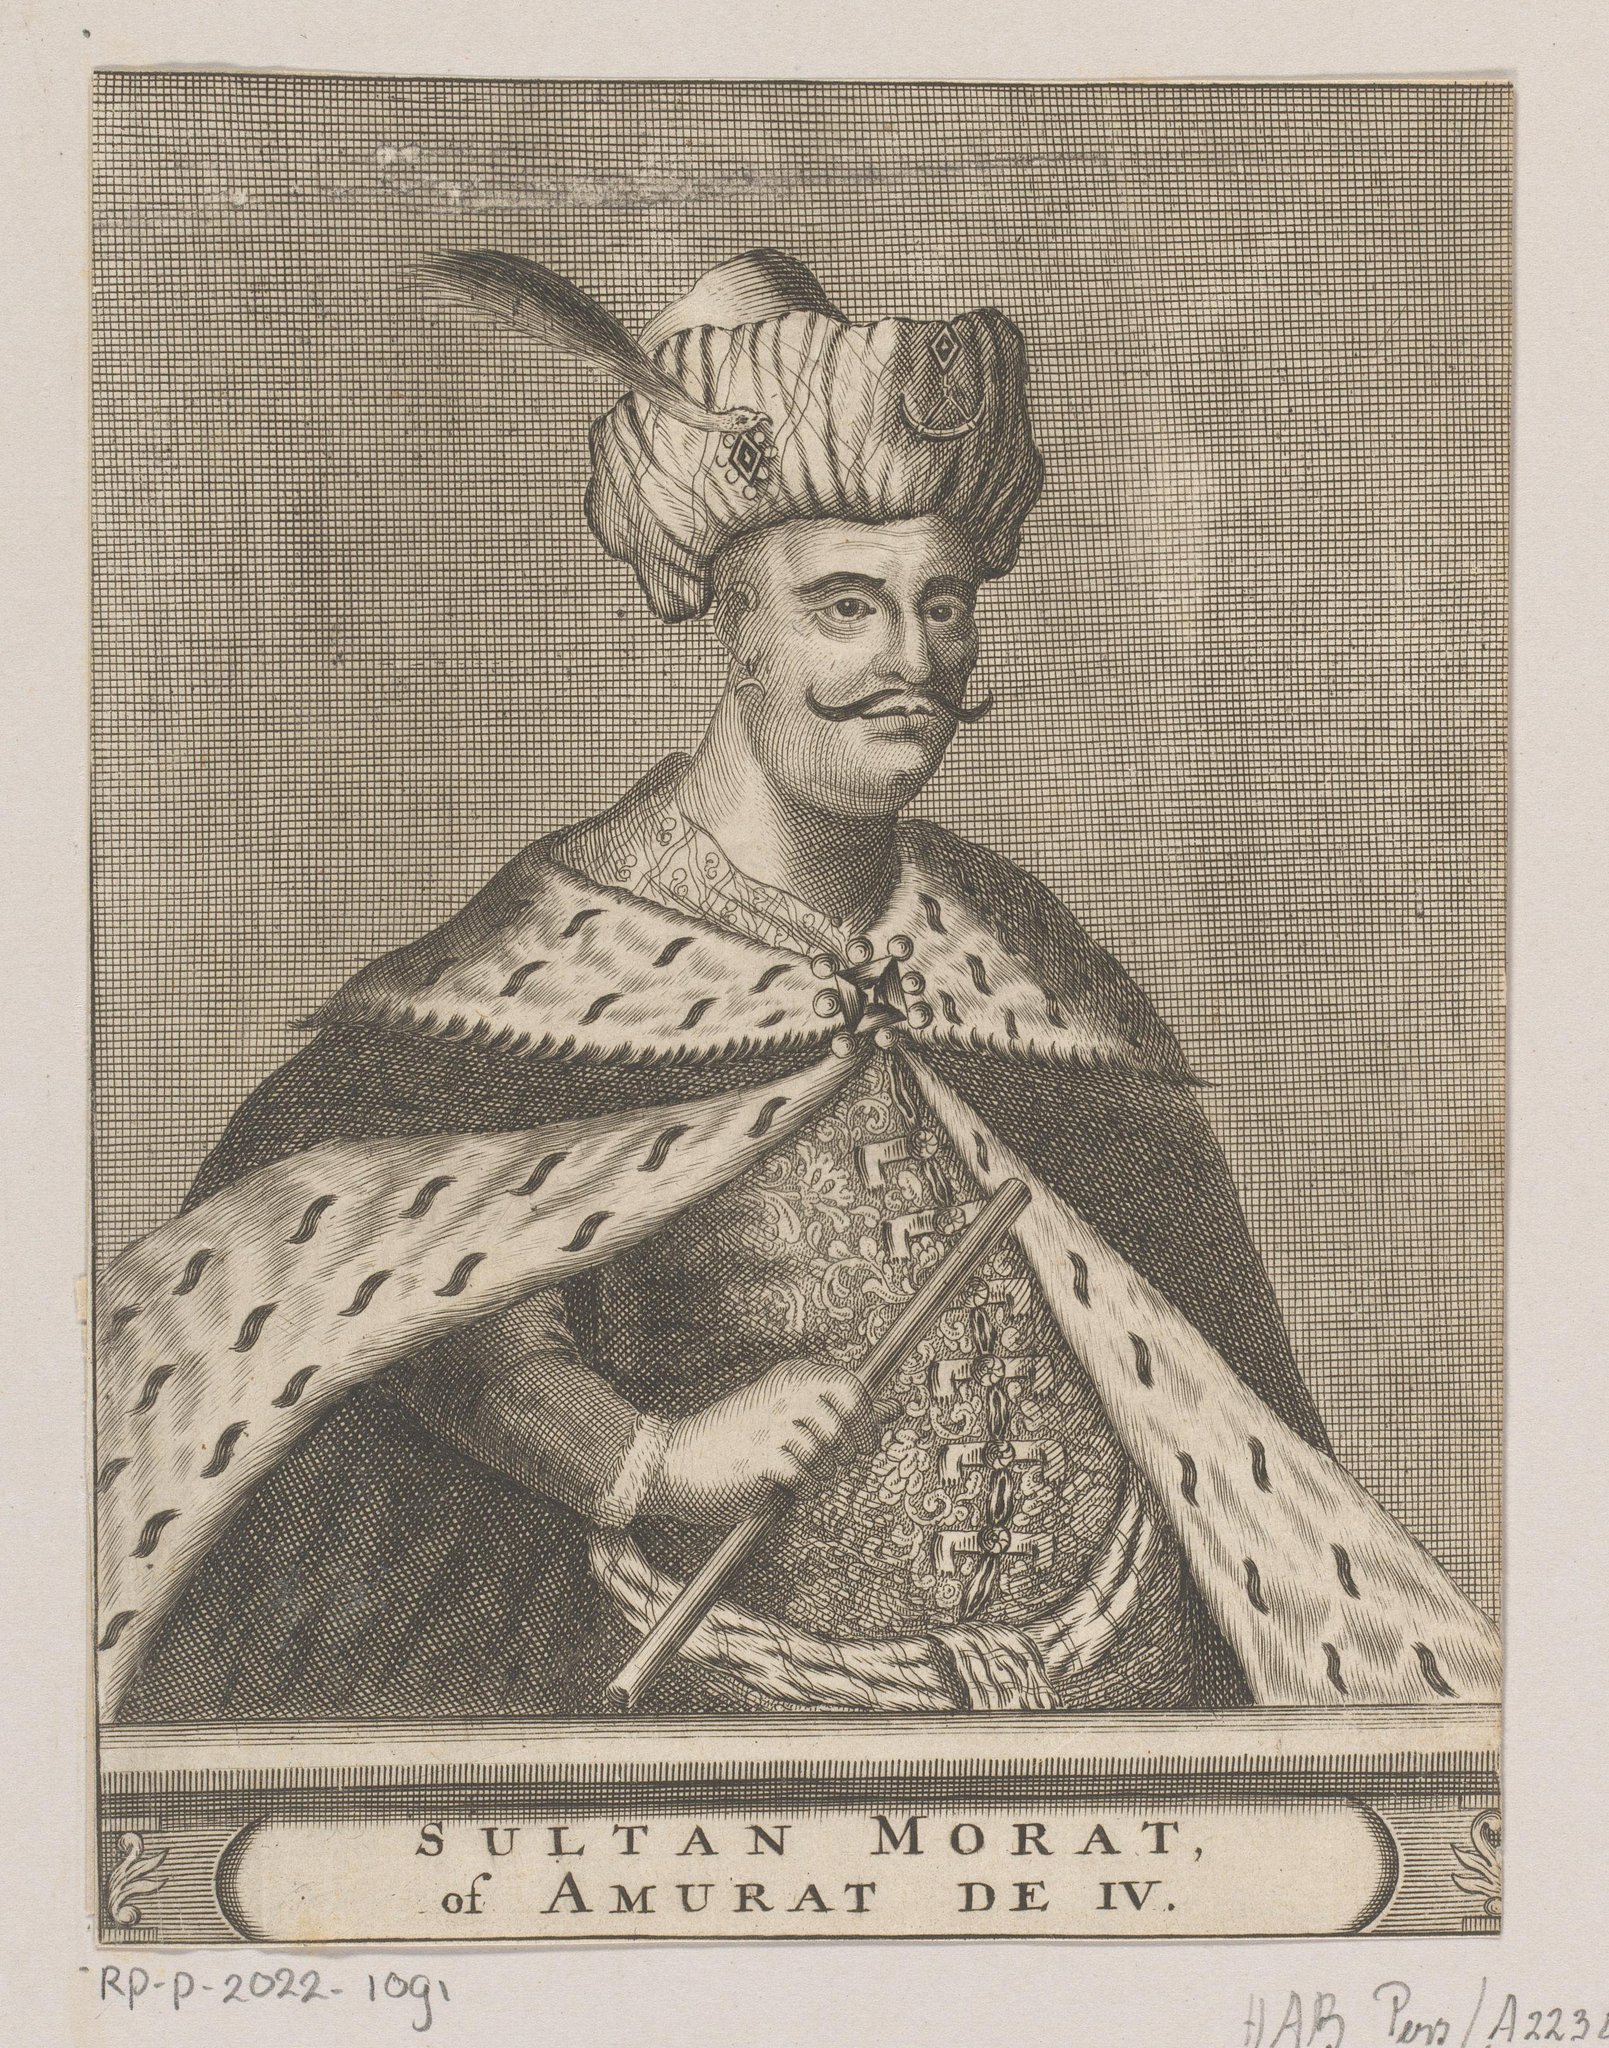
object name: print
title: Portret van Murat IV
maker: Anonymous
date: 1623-1699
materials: paper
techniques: engraving, etching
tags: historical persons, other sovereign (with title)